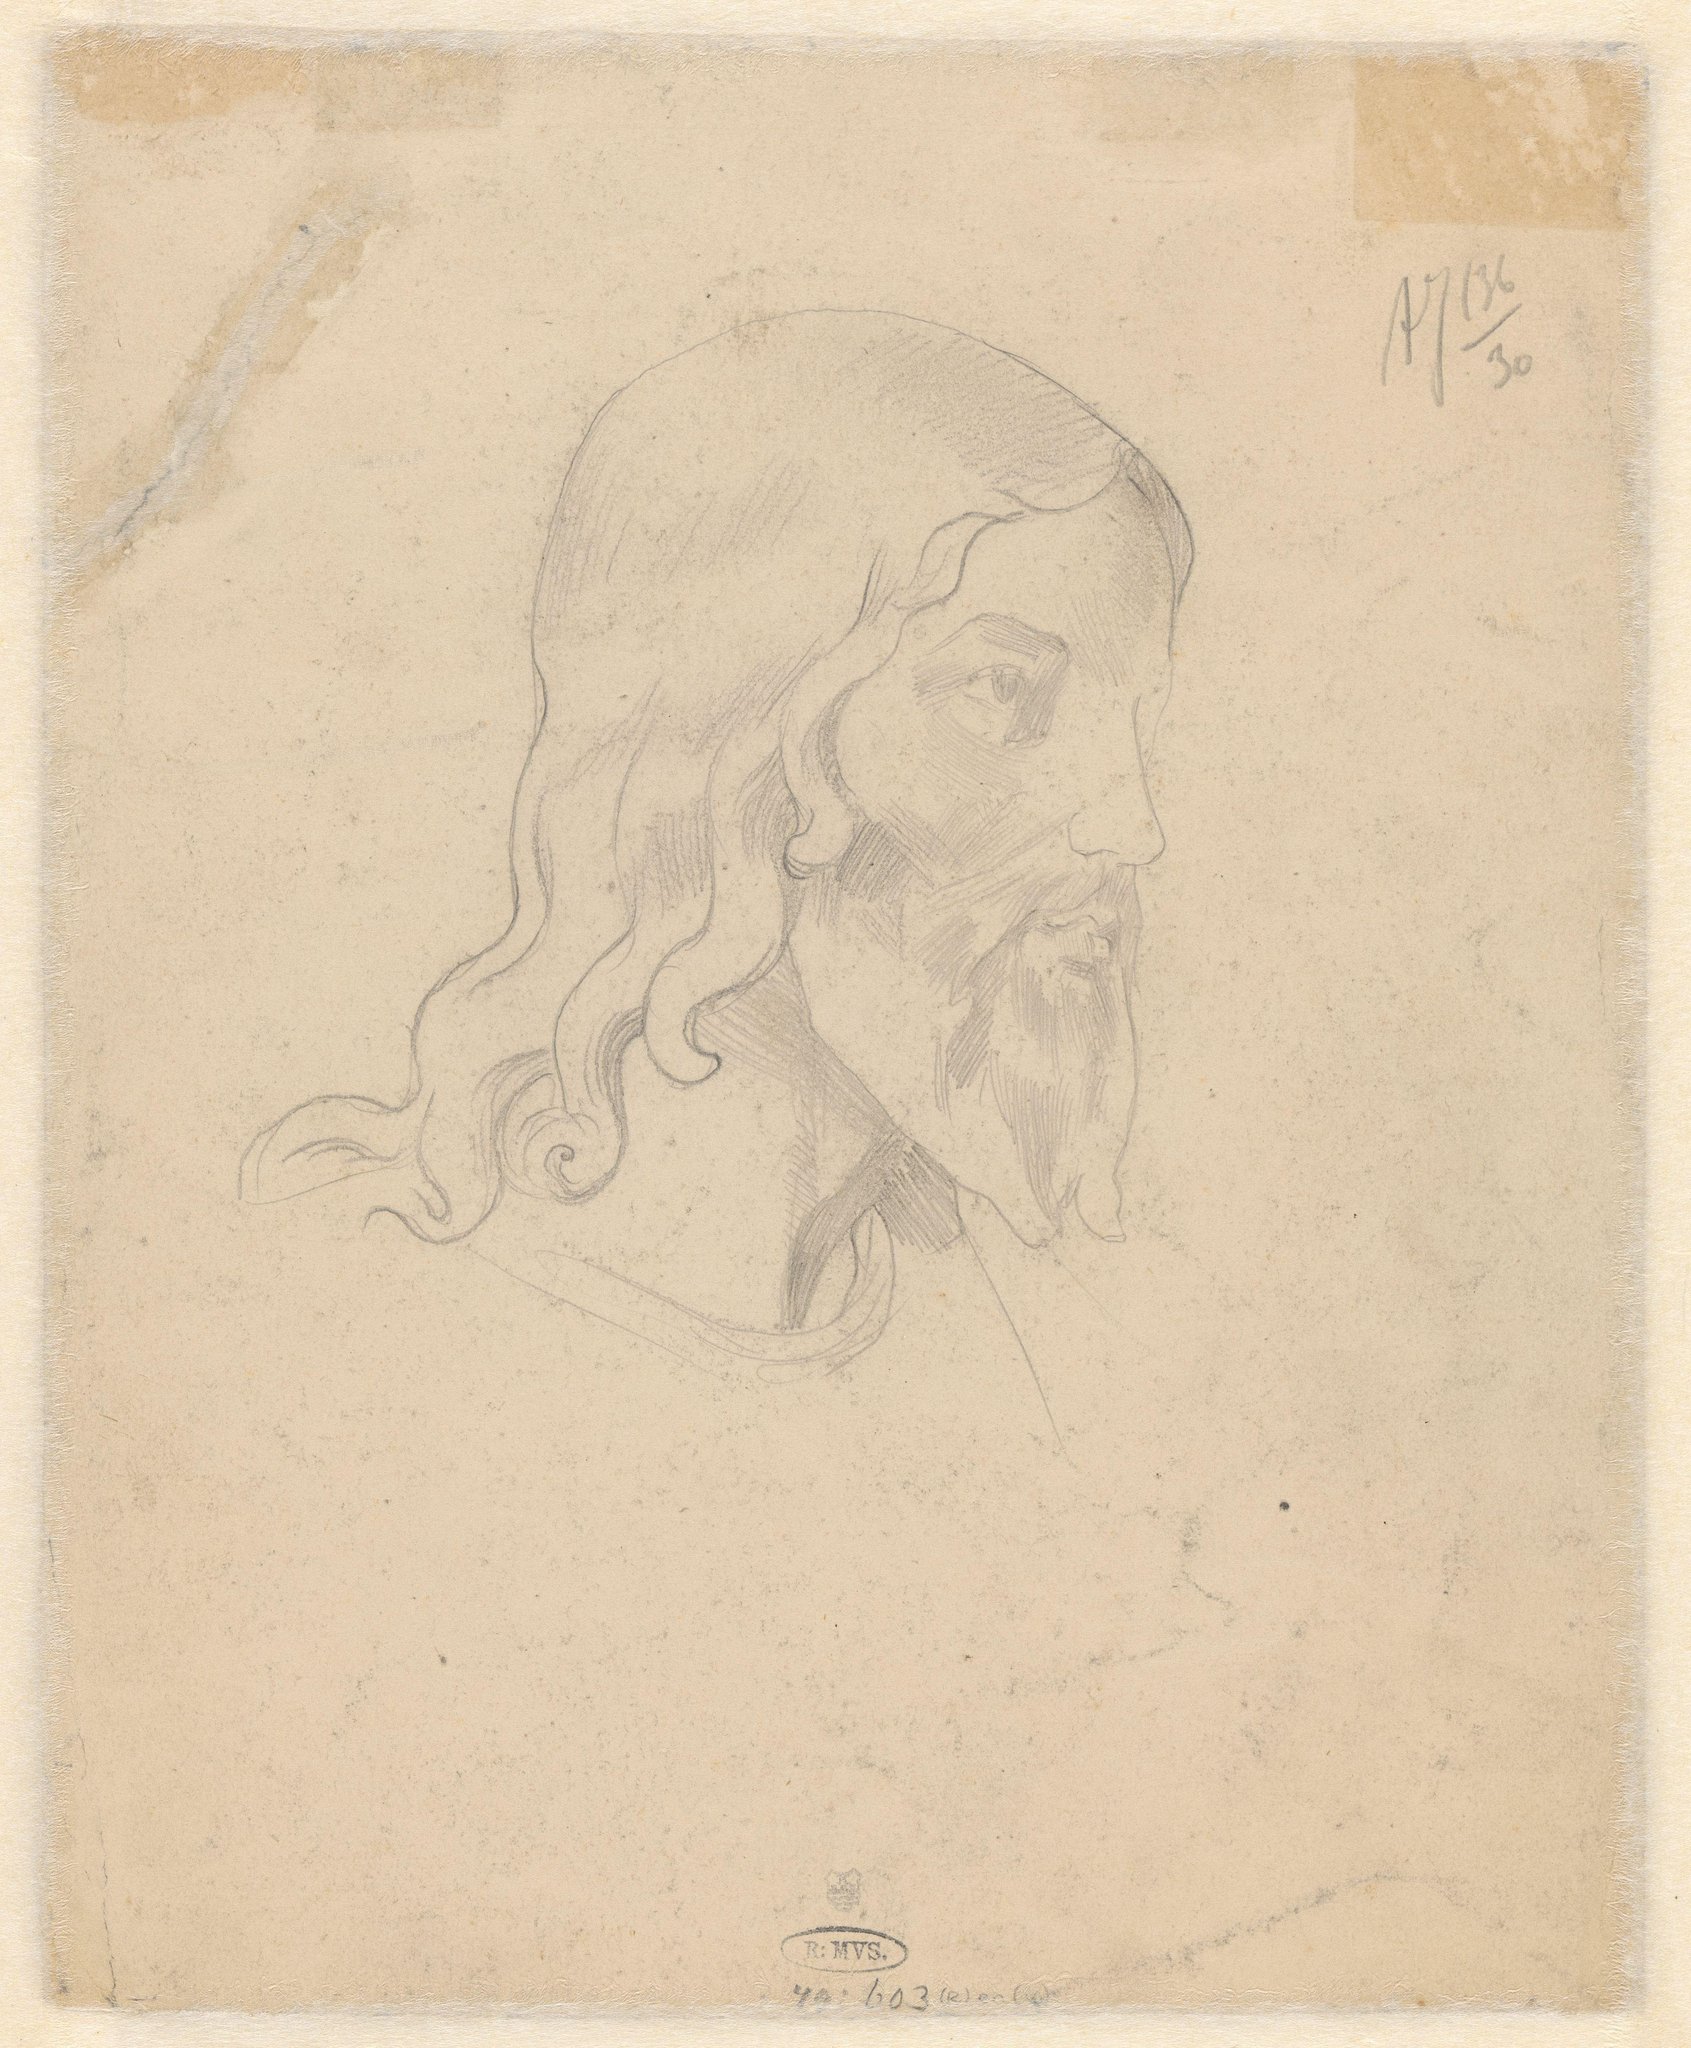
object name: drawing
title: Kop van Christus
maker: nicolaas van der waay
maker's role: draughtsman, painter, print maker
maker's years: 1855-1936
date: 1884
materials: paper, pencil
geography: florence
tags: christ as adult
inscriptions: collector's mark: Lugt 2760, annotation: ‘AJ 136/30’, collector's mark: Lugt 2228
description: De kop van Christus is getekend naar voorbeeld van het fresco 'Christus verwelkomd door twee Dominicanen' in het klooster van San Marco in Florence.